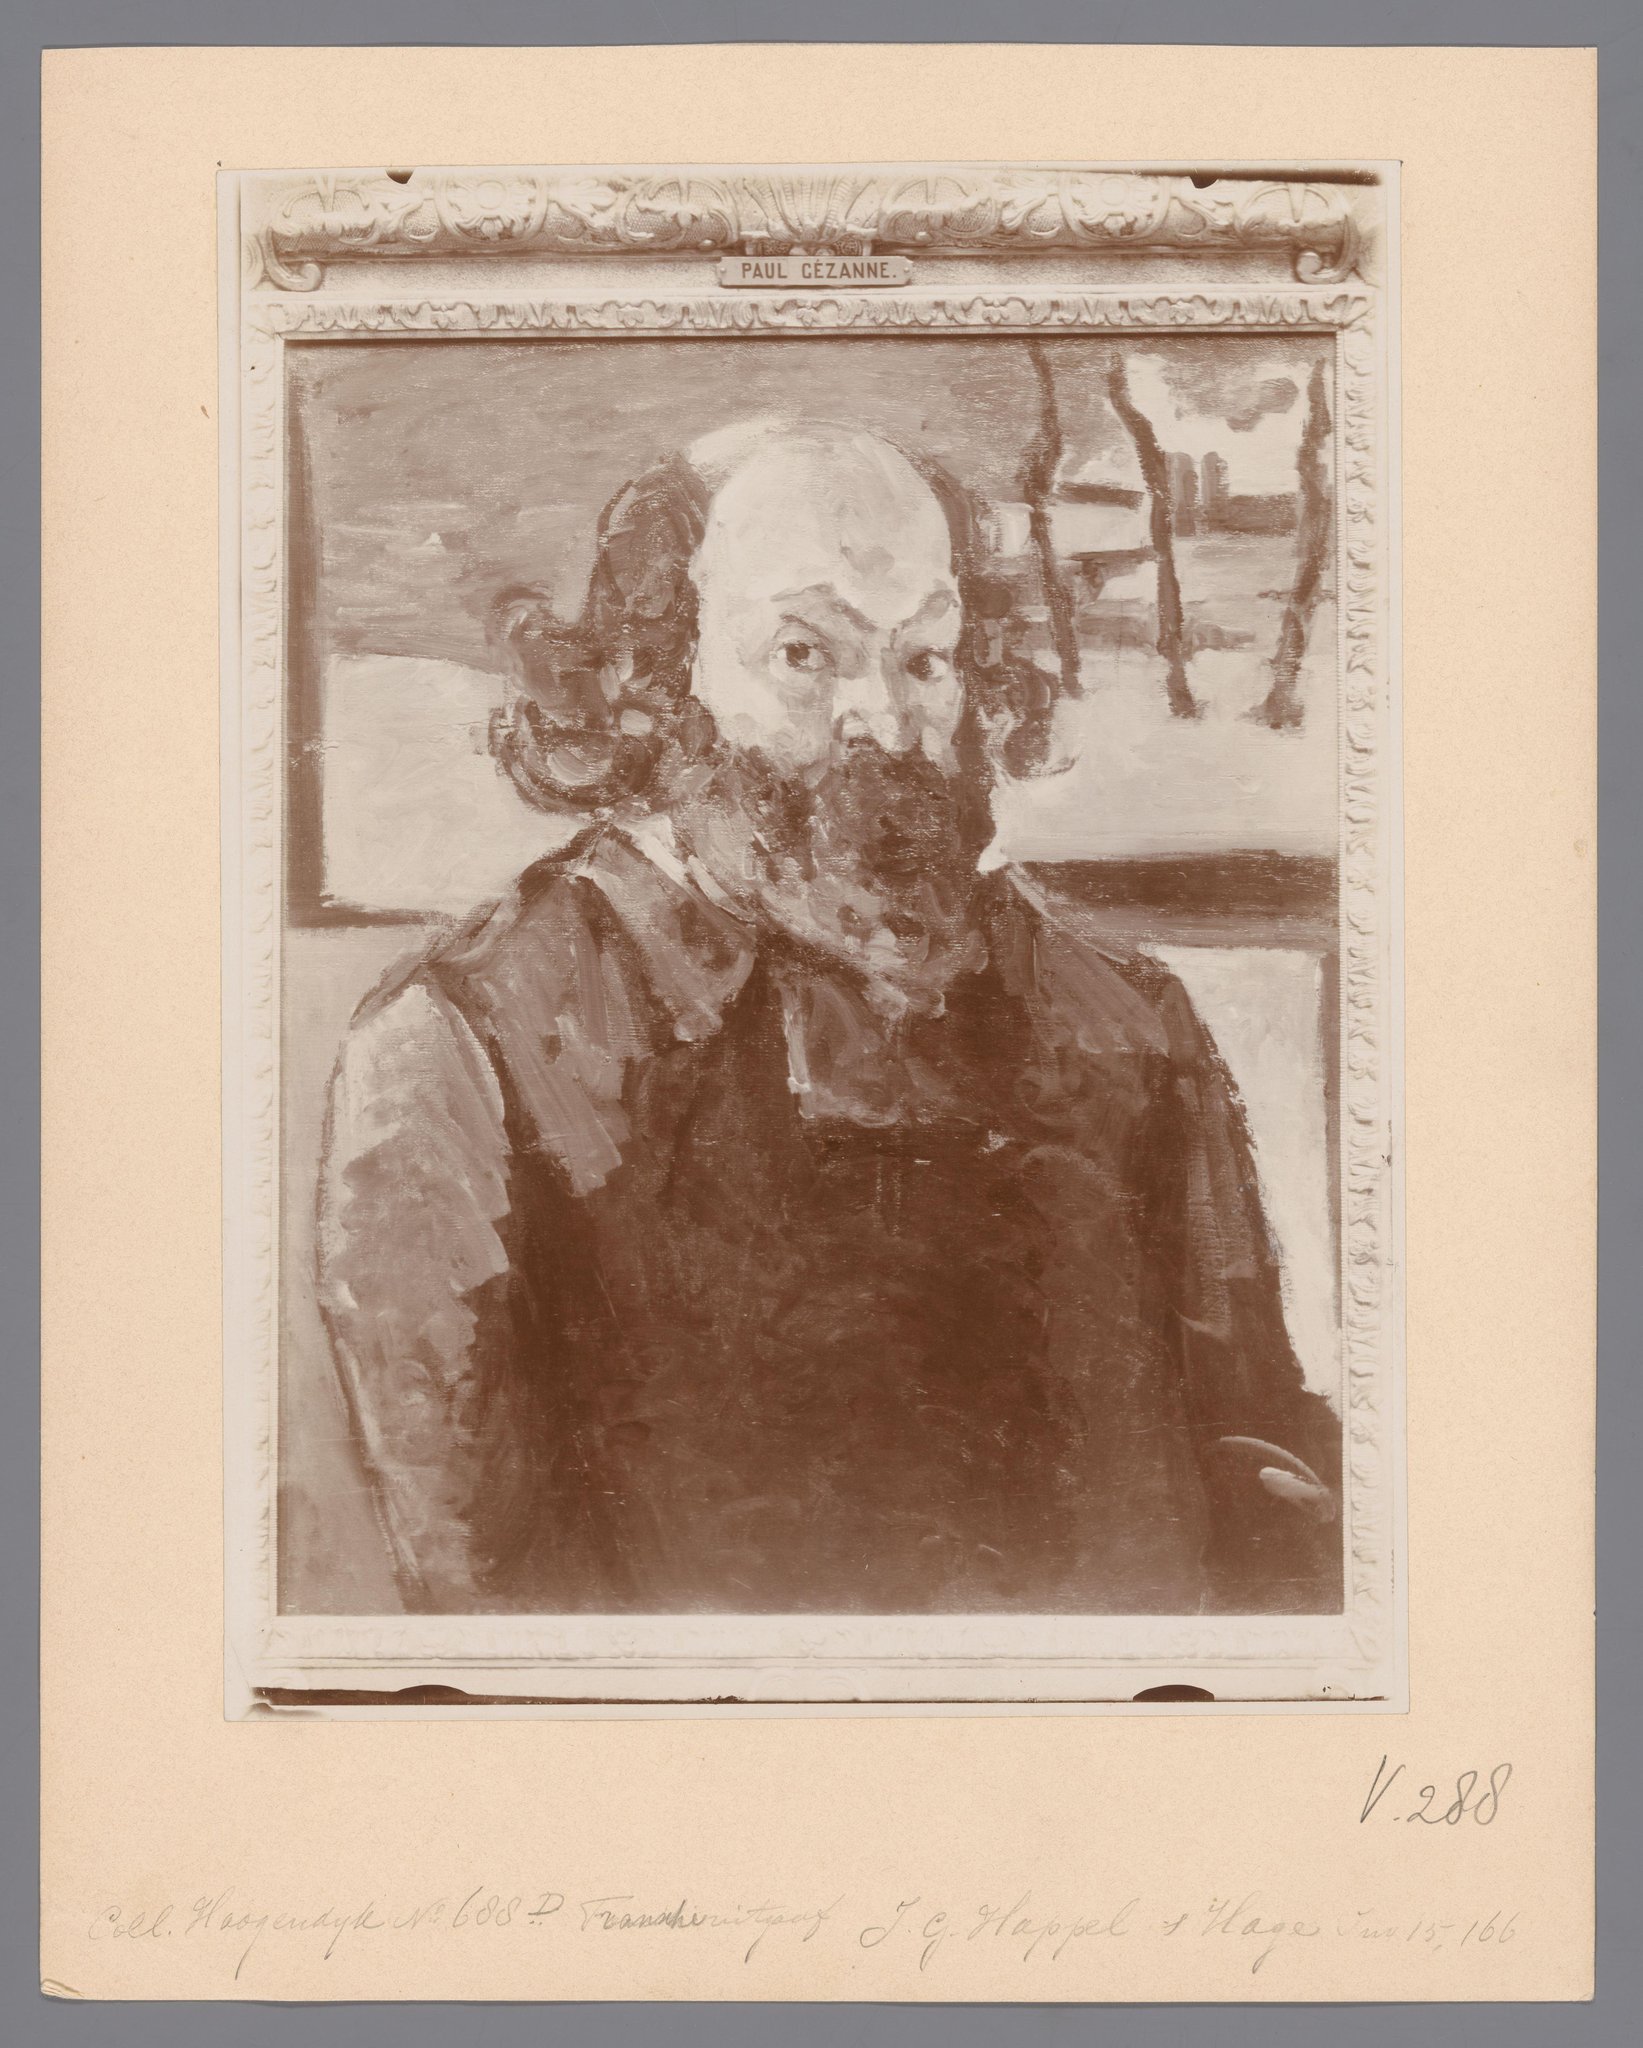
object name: reproduction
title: Fotoreproductie van een zelfportret uit de collectie Hoogendijk, nu in Musée d'Orsay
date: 1915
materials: cardboard, paper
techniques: albumen print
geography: the hague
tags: print maker, draughtsman, paul cézanne, portrait, self-portrait of artist, picture, painting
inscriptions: collector's mark: Lugt 2228, number: ‘No. 21.’, inscription: ‘15.166’, inscription: ‘Coll. Hoogendijk No. 688D F[...]J.G. Happel s Hage Inv 15,166’, inscription: ‘V.288’